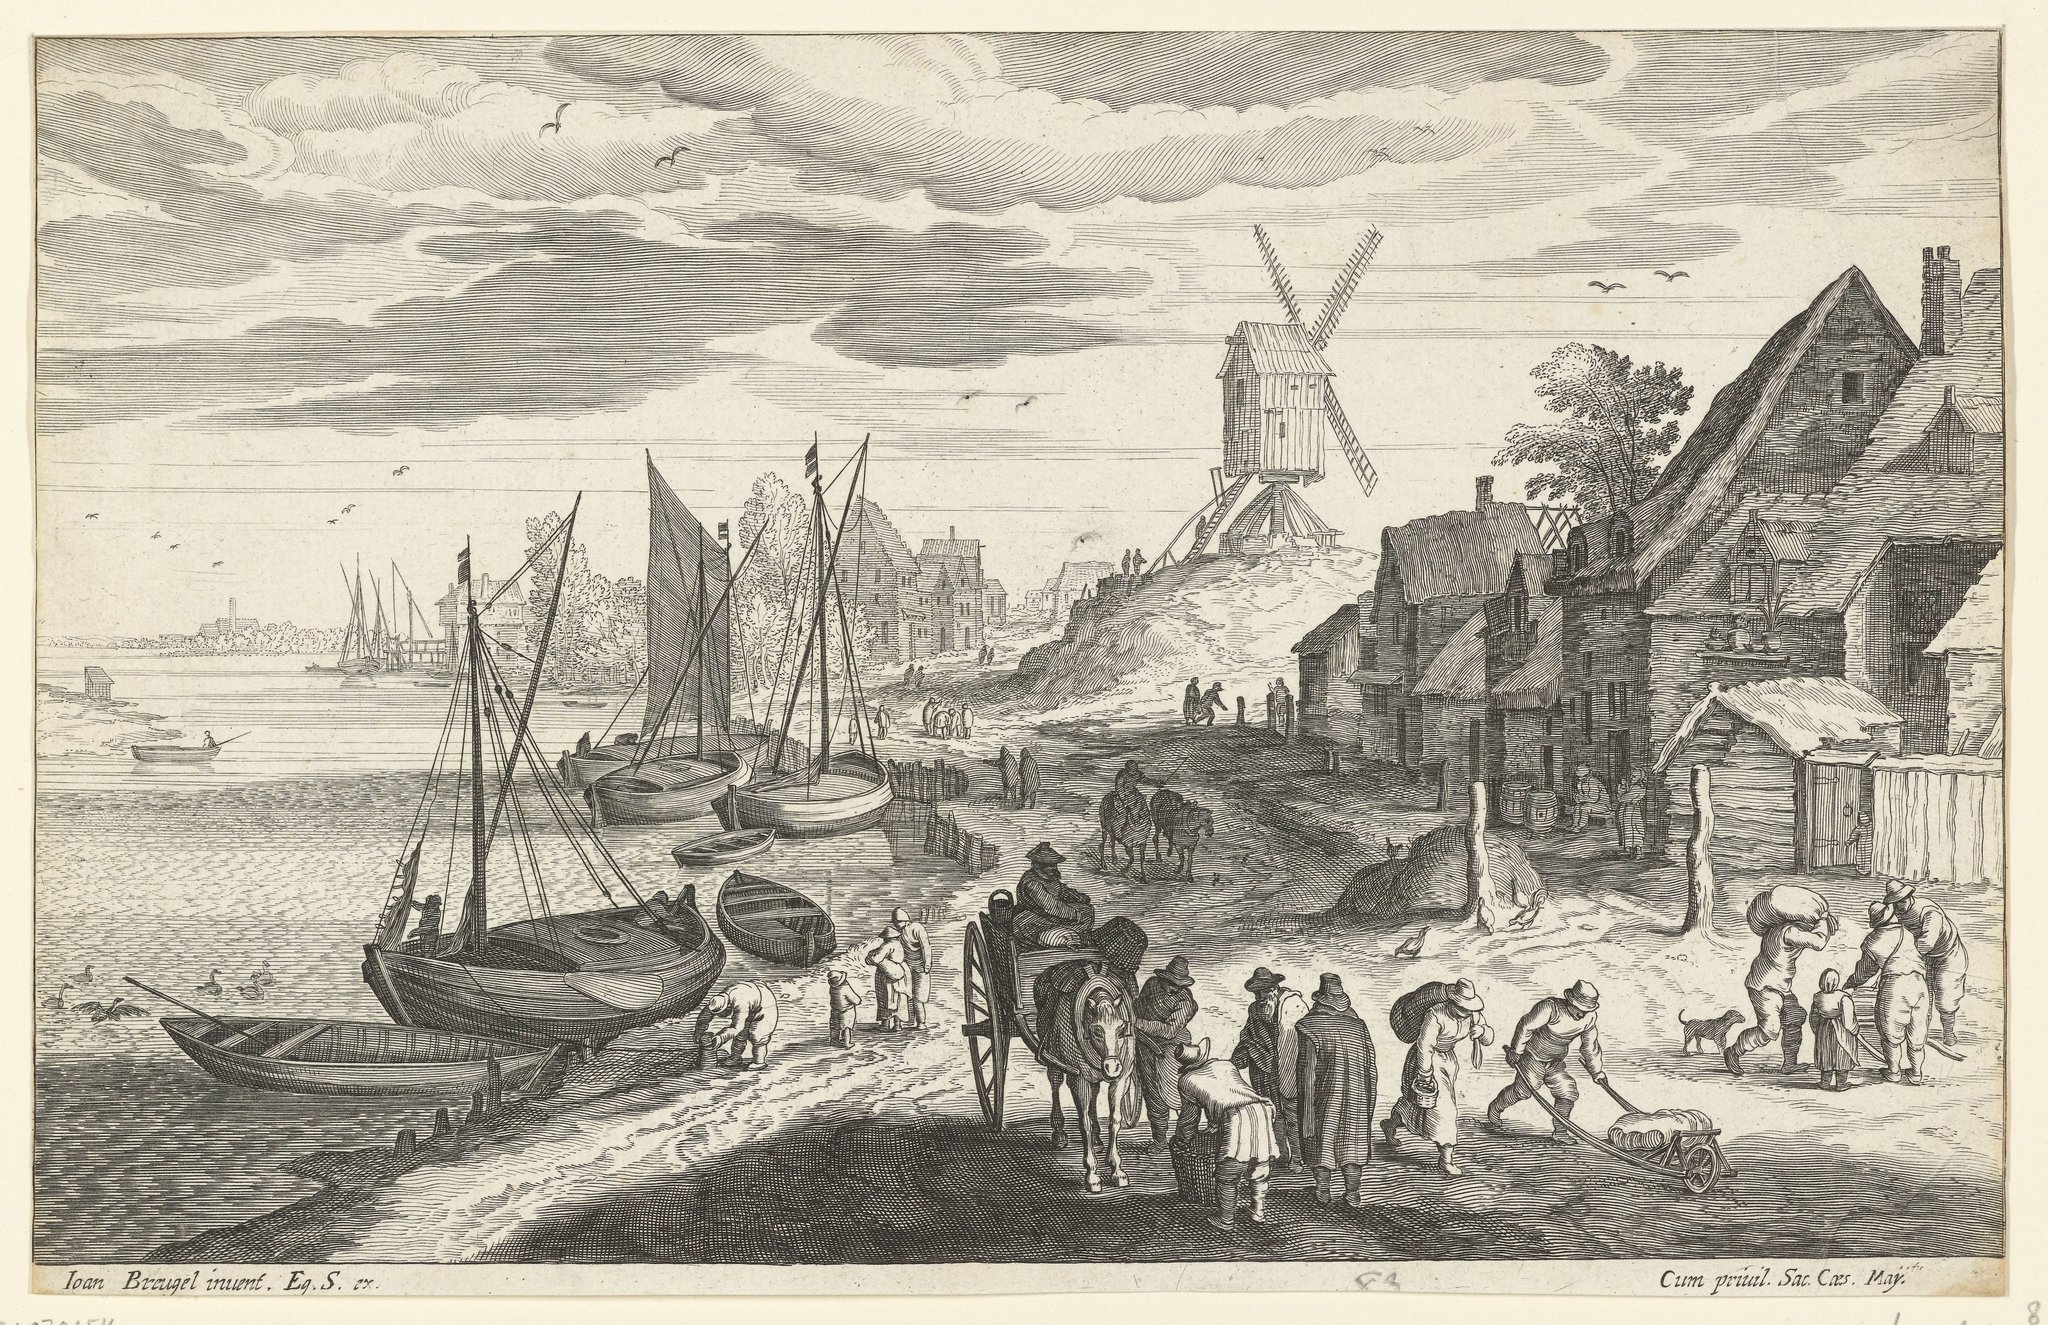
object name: print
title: Landschap aan de kust met windmolen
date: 1580-1629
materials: paper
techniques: engraving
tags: sailing-ship, sailing-boat, windmill in landscape, coast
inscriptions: collector's mark: Lugt 2228, collector's mark: Lugt 2760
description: In het water liggen aangemeerde vissersbootjes. In het midden een kustweg met figuren langs een rijtje houten huizen. Op de achtergrond een molen op een heuvel.